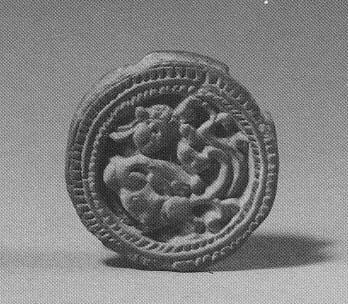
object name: ear plug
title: Ear Plug with Kinnari (Half-Bird, Half-Female Creature)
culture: indian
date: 401-500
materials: terracotta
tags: gupta,mythical creatures